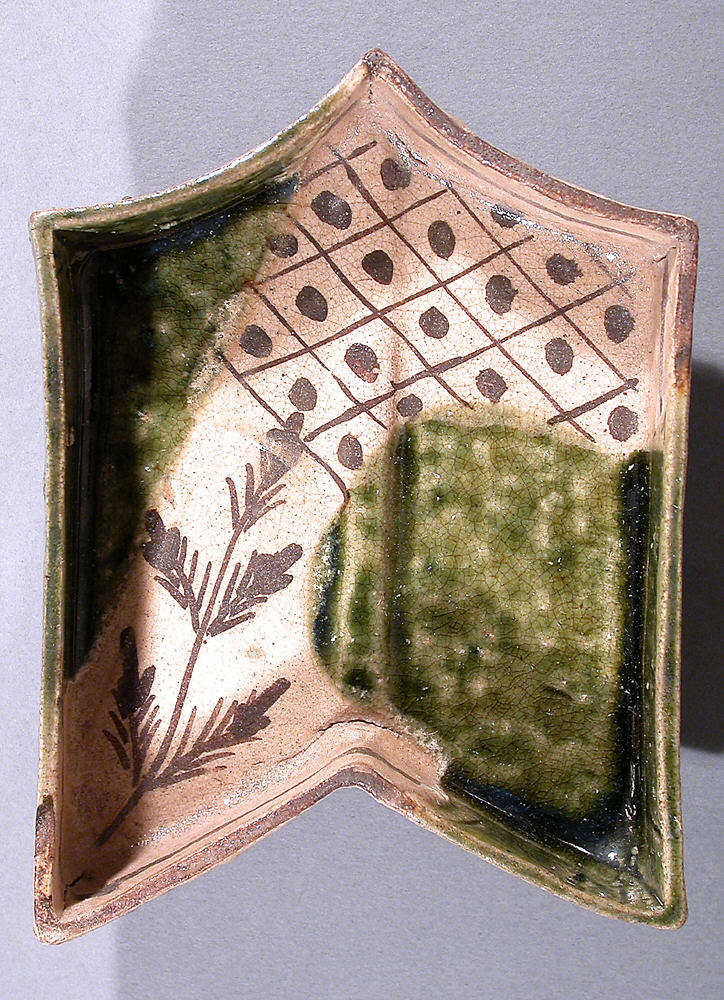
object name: dish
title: Dish in the Shape of an Arrow's Fletching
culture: japanese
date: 1601-1633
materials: copper, glaze, iron, stoneware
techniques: underglaze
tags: leaves